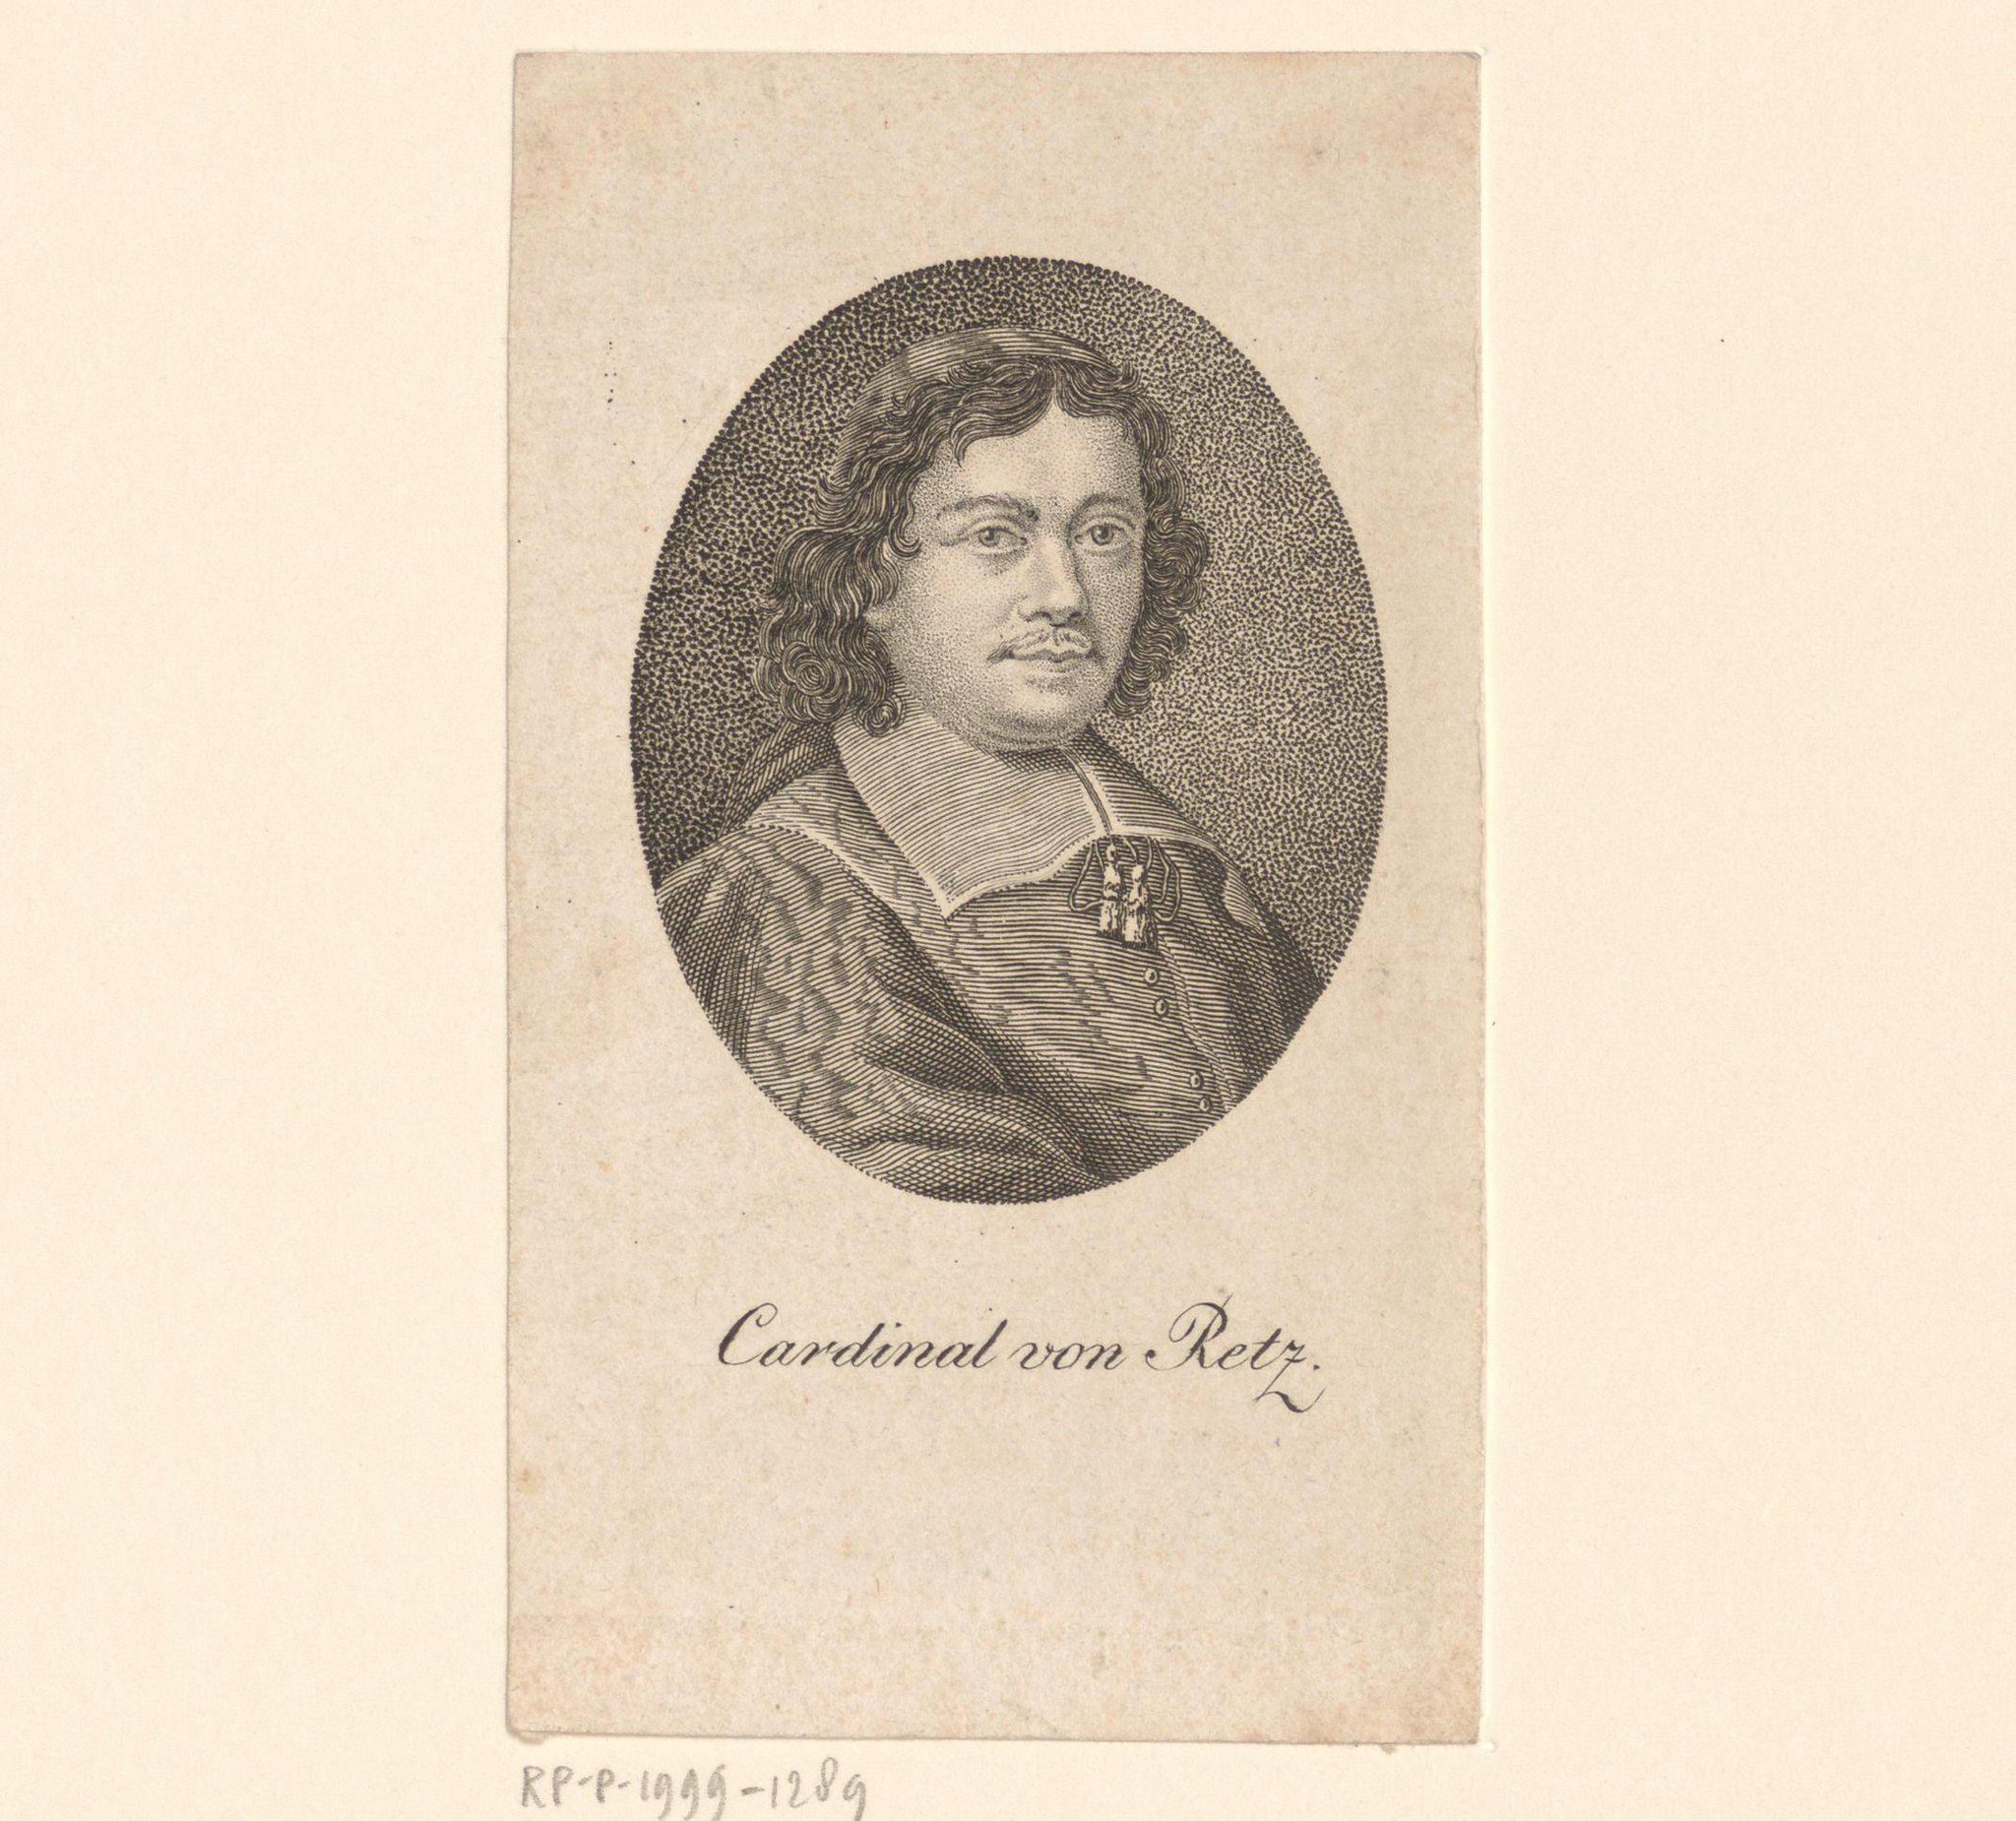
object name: print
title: Portret van Jean-François Paul de Gondi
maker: Anonymous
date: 1652-1749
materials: paper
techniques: engraving, etching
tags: paris, cardinal, historical persons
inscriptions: collector's mark: Briquet 2760, collector's mark: Lugt 2228